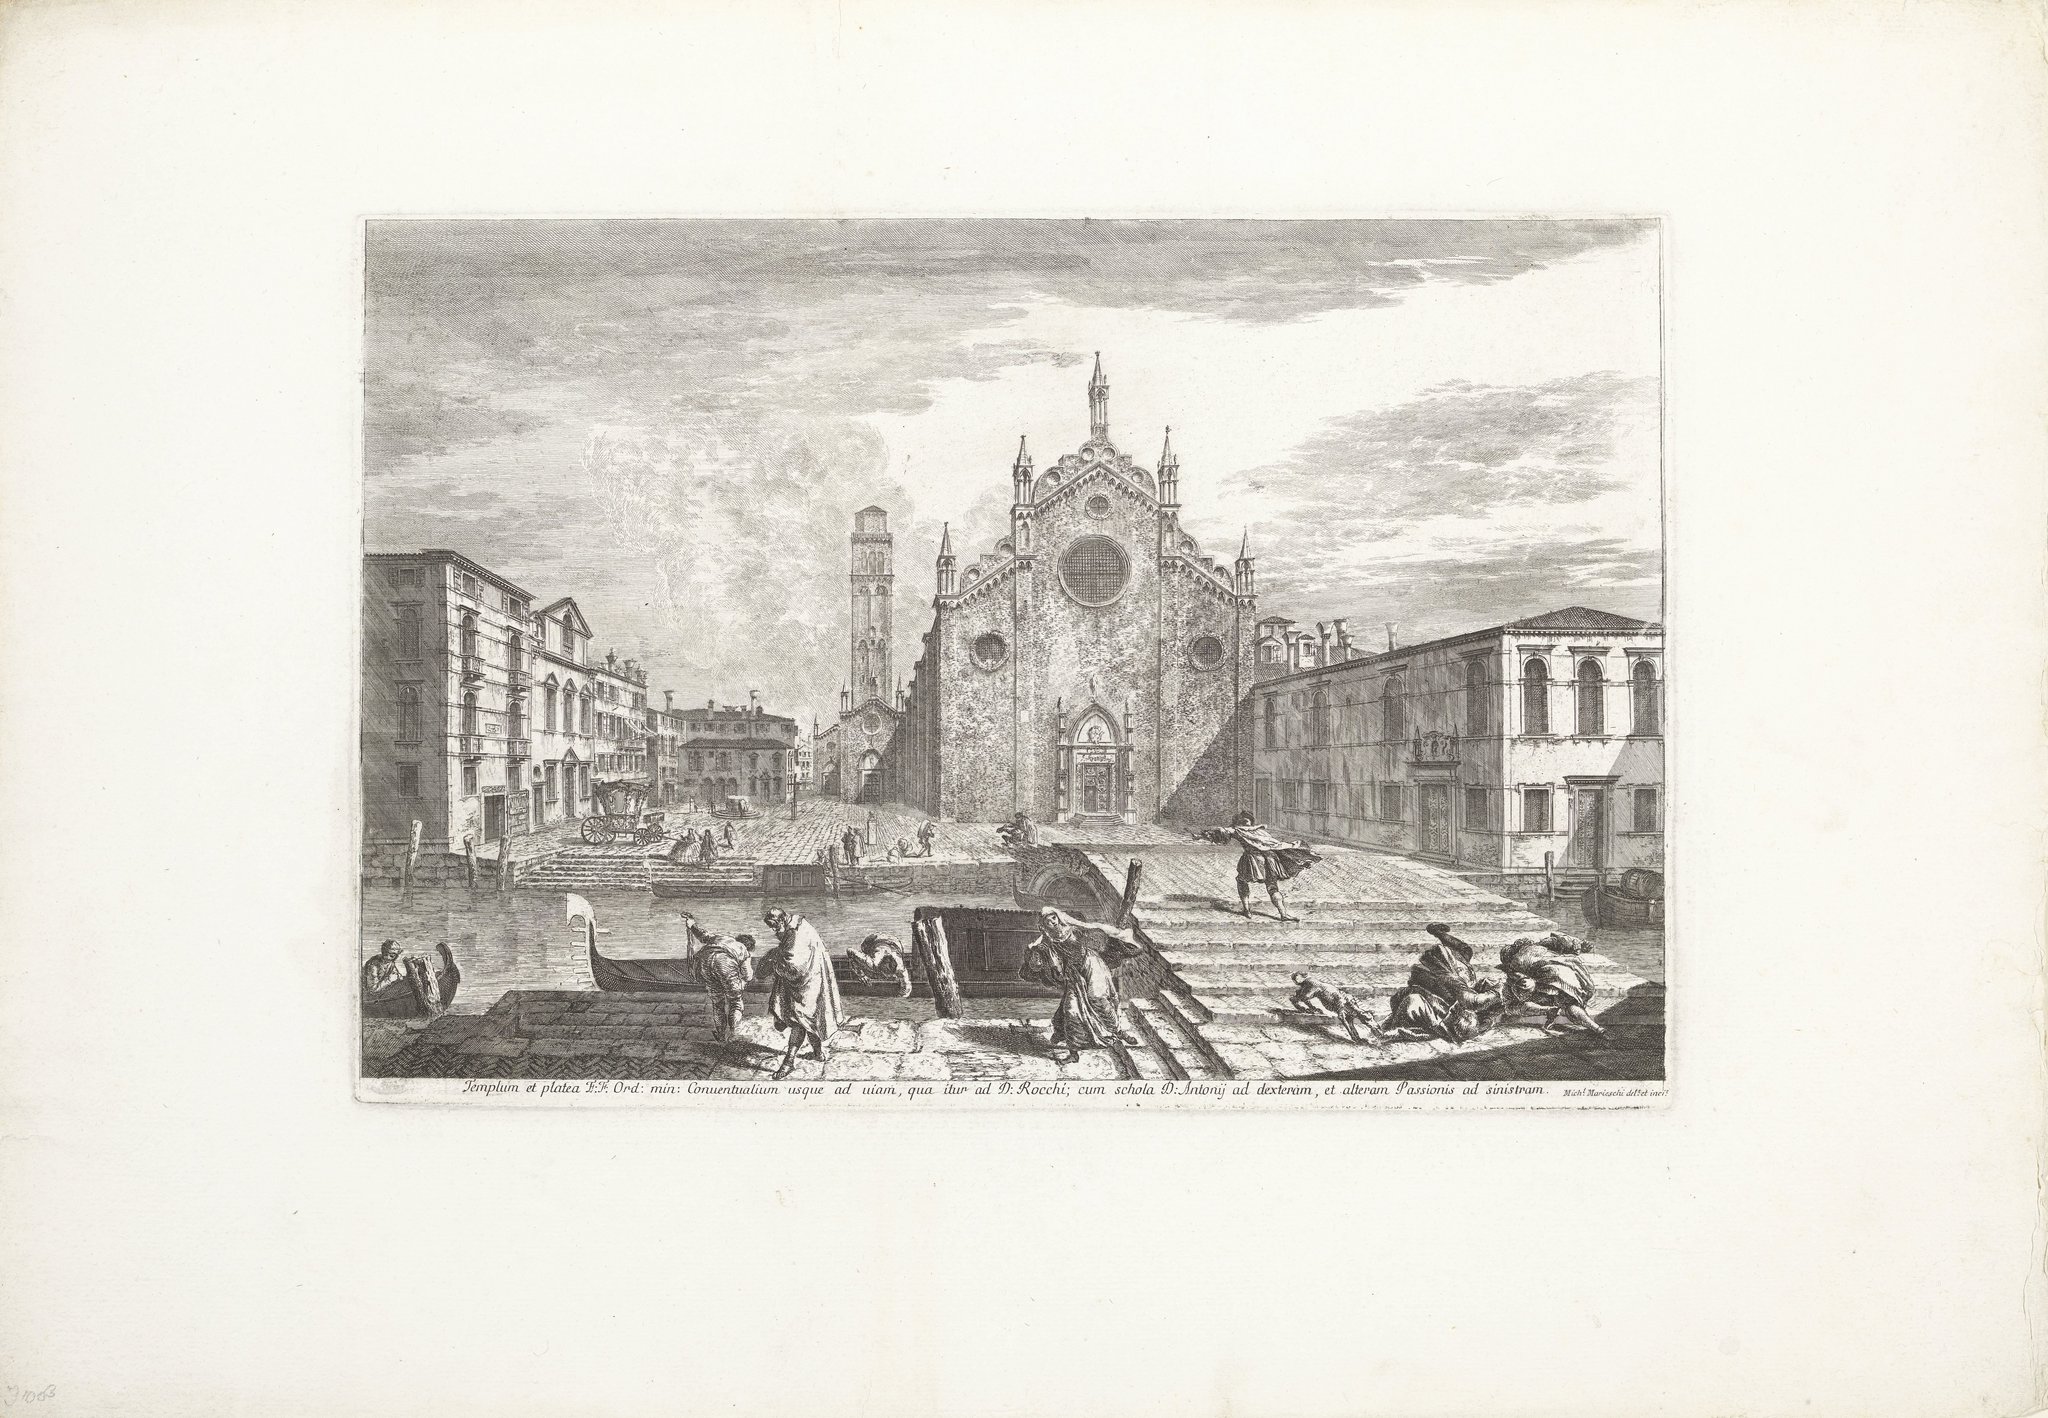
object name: print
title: Templum et platea F.F. Ord: min: Conventualium usque ad viam (...)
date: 1741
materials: paper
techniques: engraving, etching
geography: venice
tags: archive, city-view, and landscape with man-made constructions, church (exterior), gondola, venice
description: Gezicht op de Santa Maria Gloriosa dei Frari en het Archivio di Stato te Venetië.